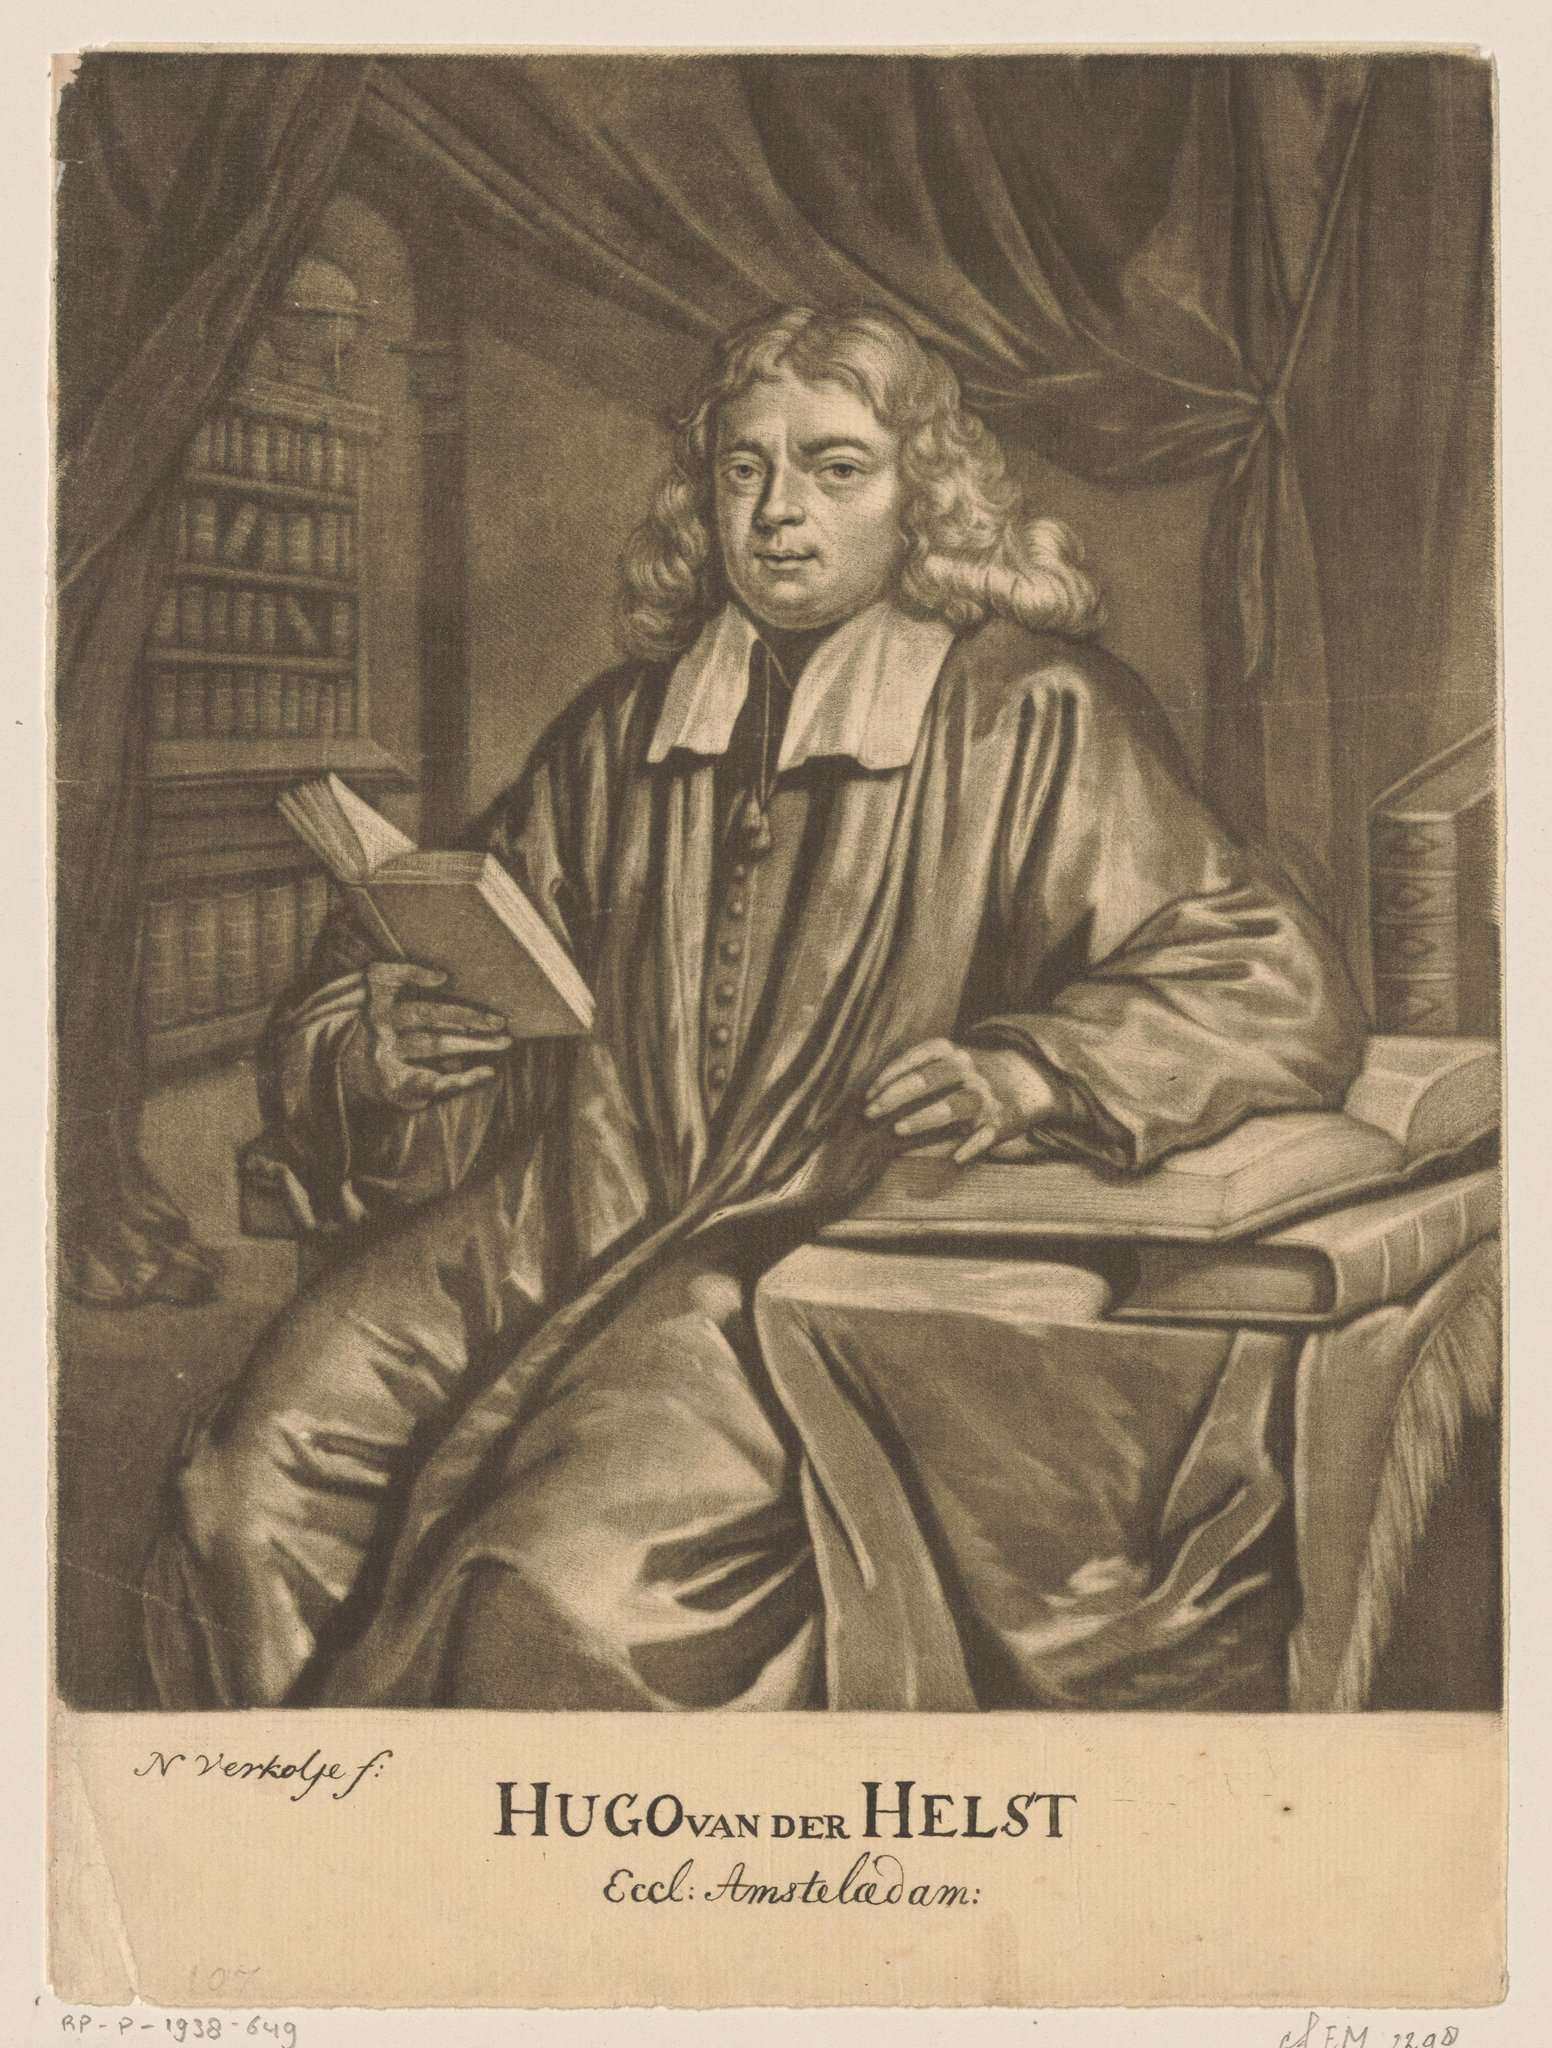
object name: print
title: Portret van Hugo van der Helst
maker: nicolaas verkolje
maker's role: draughtsman, painter, print maker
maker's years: 1673-1746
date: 1683-1746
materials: paper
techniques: engraving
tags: bookshelves, historical persons, book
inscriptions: collector's mark: Lugt 2228